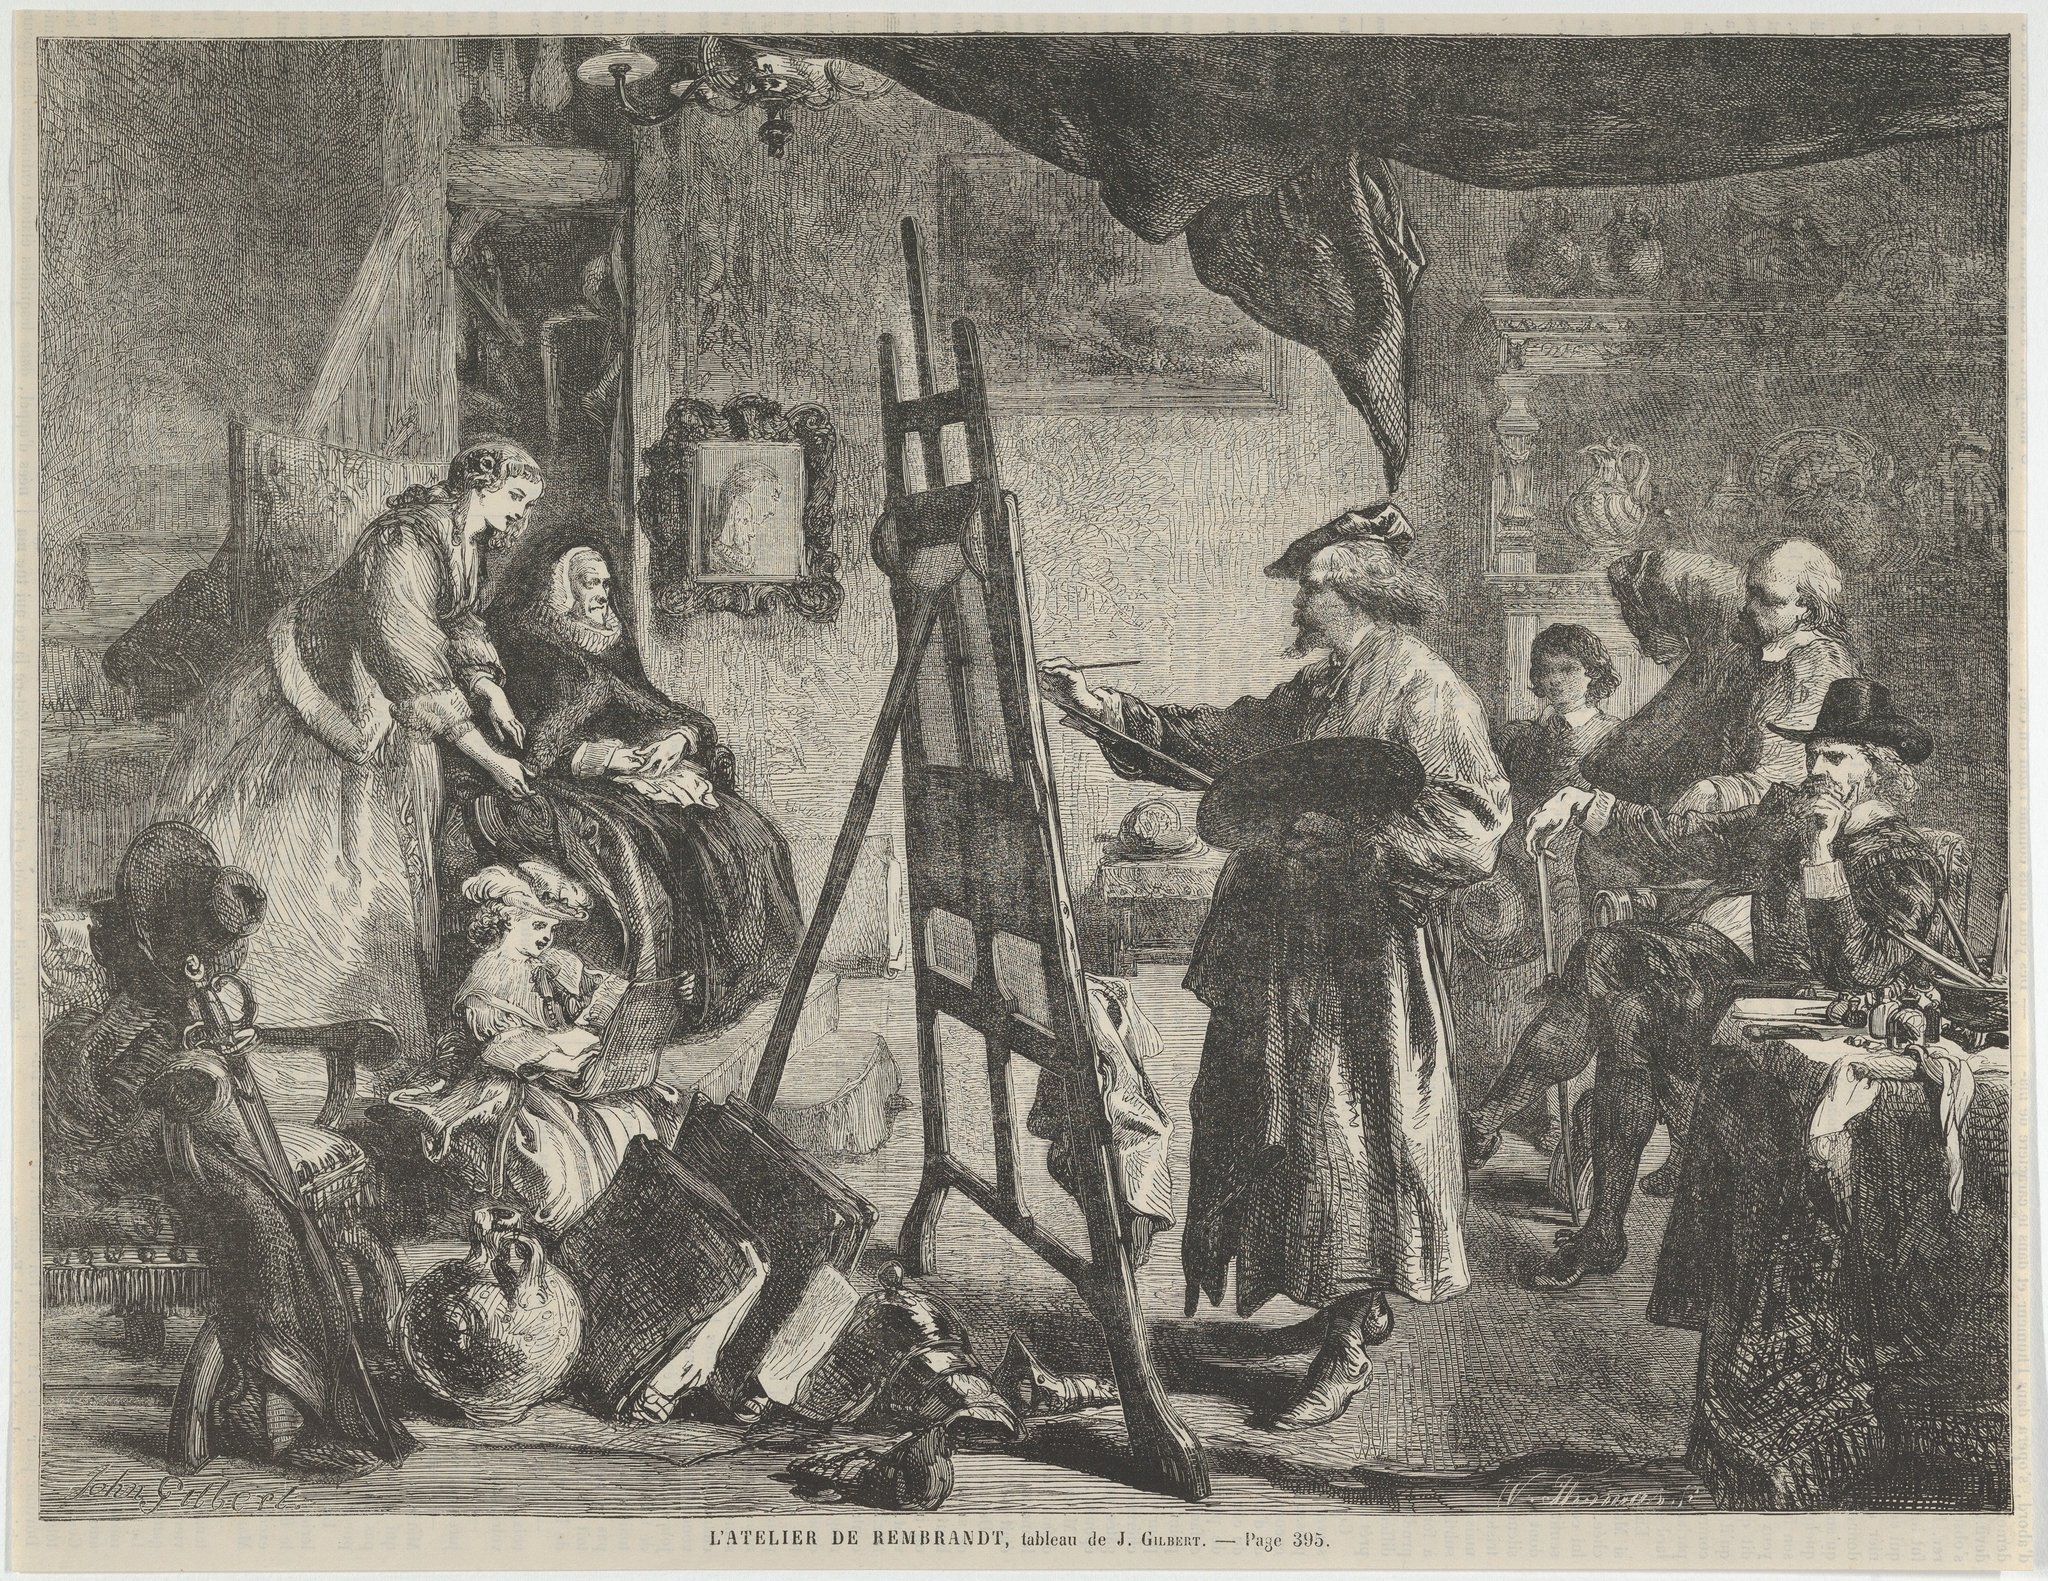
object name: print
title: L'Atelier de Rembrandt, tableau de J. Gilbert (Rembrandt's Studio, a painting by J. Gilbert), from "L'Univers Illustré," p. 395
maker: william luson thomas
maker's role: engraver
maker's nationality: british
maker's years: 1830-1900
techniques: engraving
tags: painting,men,women